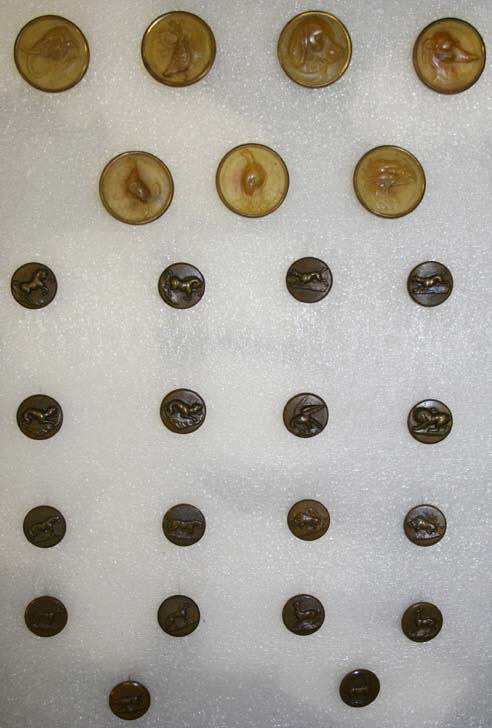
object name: button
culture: british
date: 1850-1900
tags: birds,dogs,elephants,horses